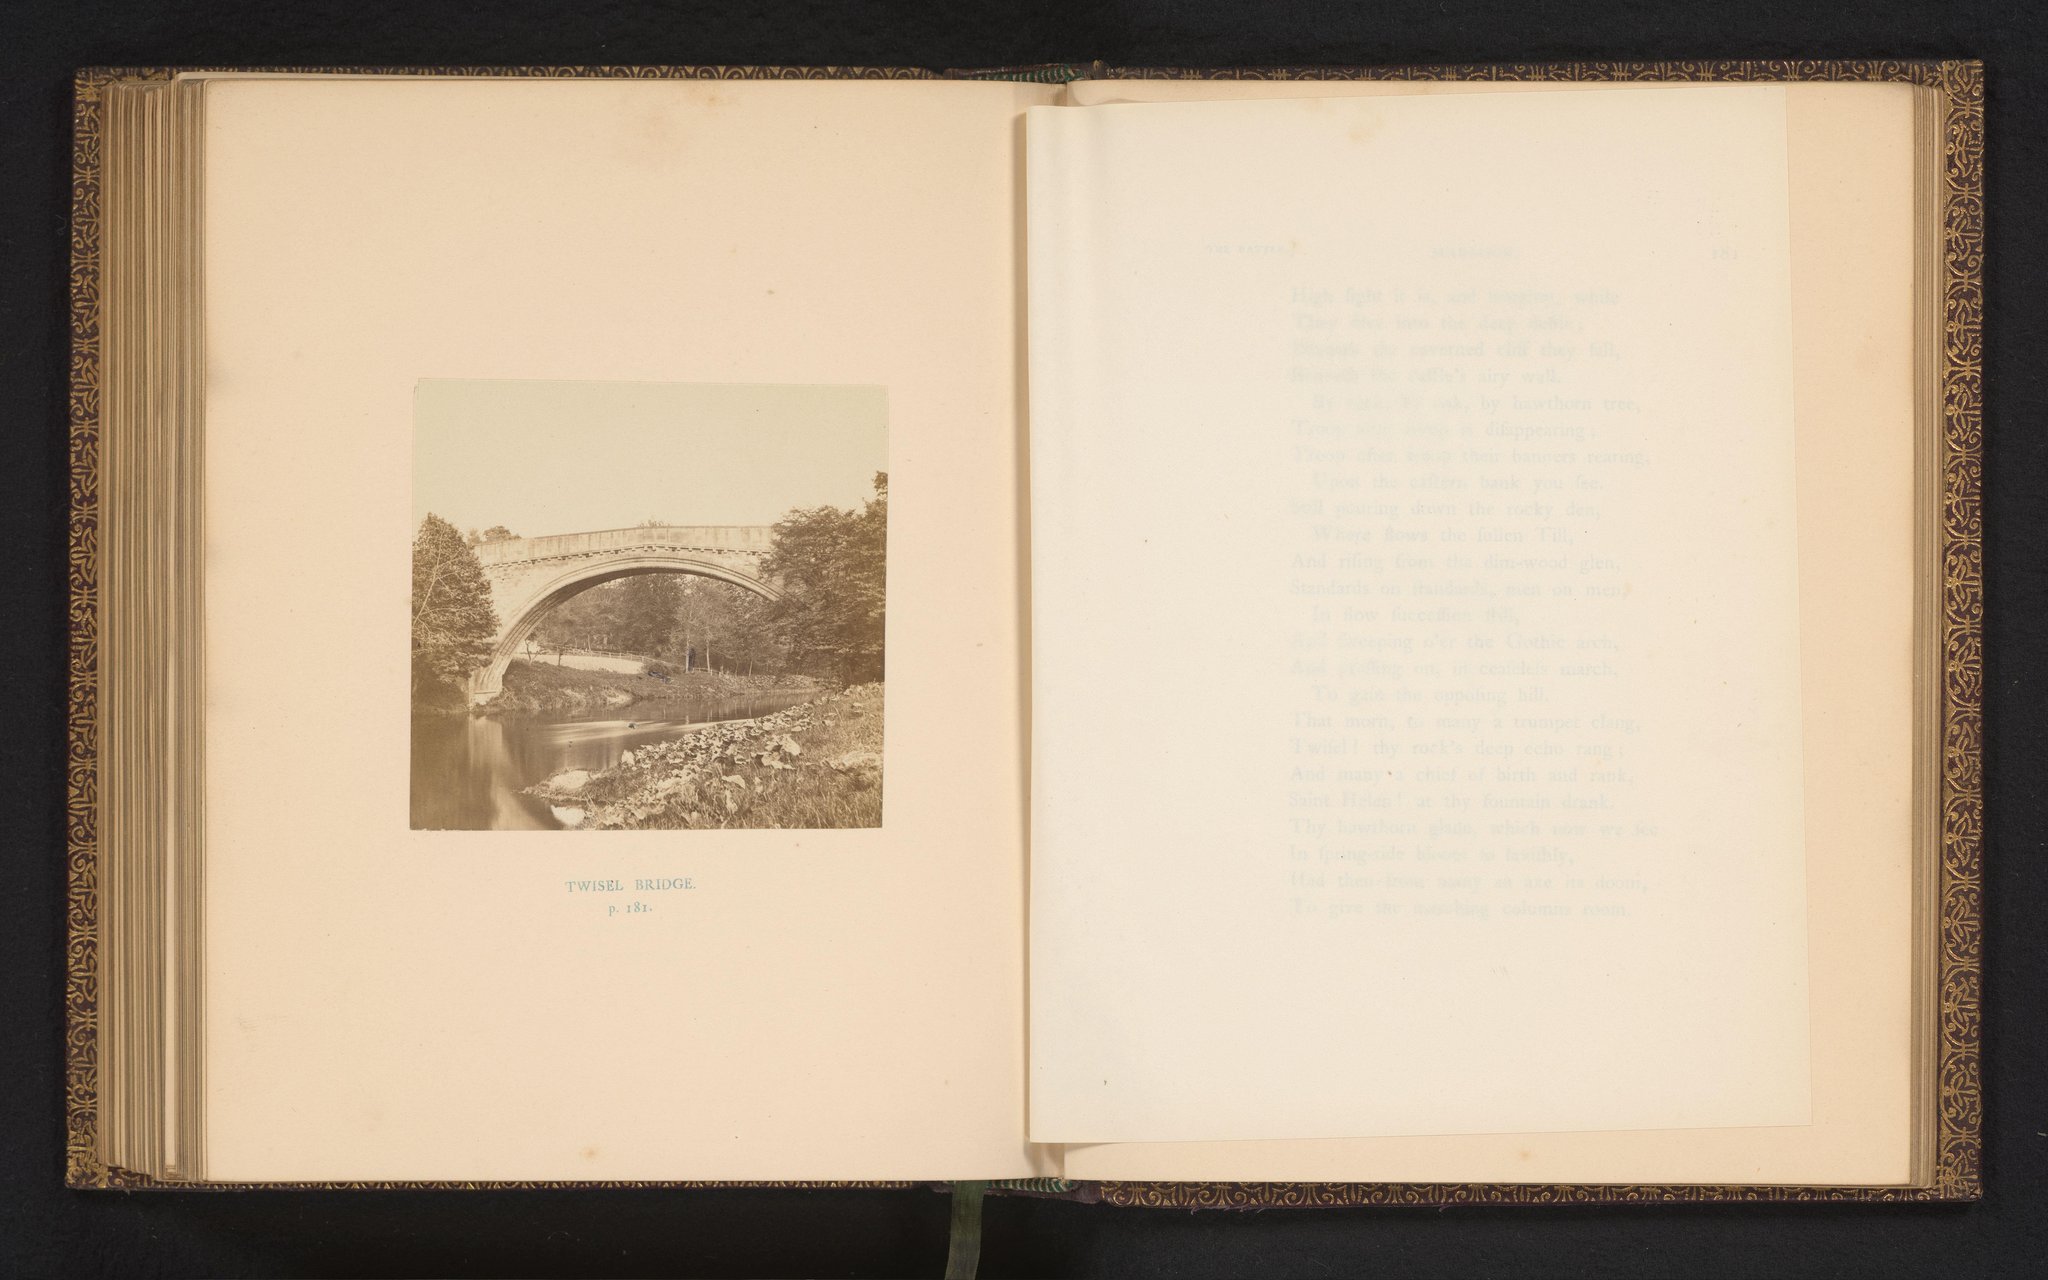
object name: page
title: Twisel Bridge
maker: thomas annan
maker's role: fotograaf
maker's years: 1829-1887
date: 1861-1866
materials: paper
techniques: albumen print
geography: cornhill-on-tweed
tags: river, bridge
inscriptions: inscription: ‘p. 181.’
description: Foto op ongenummerde pagina tegenover pagina 181.